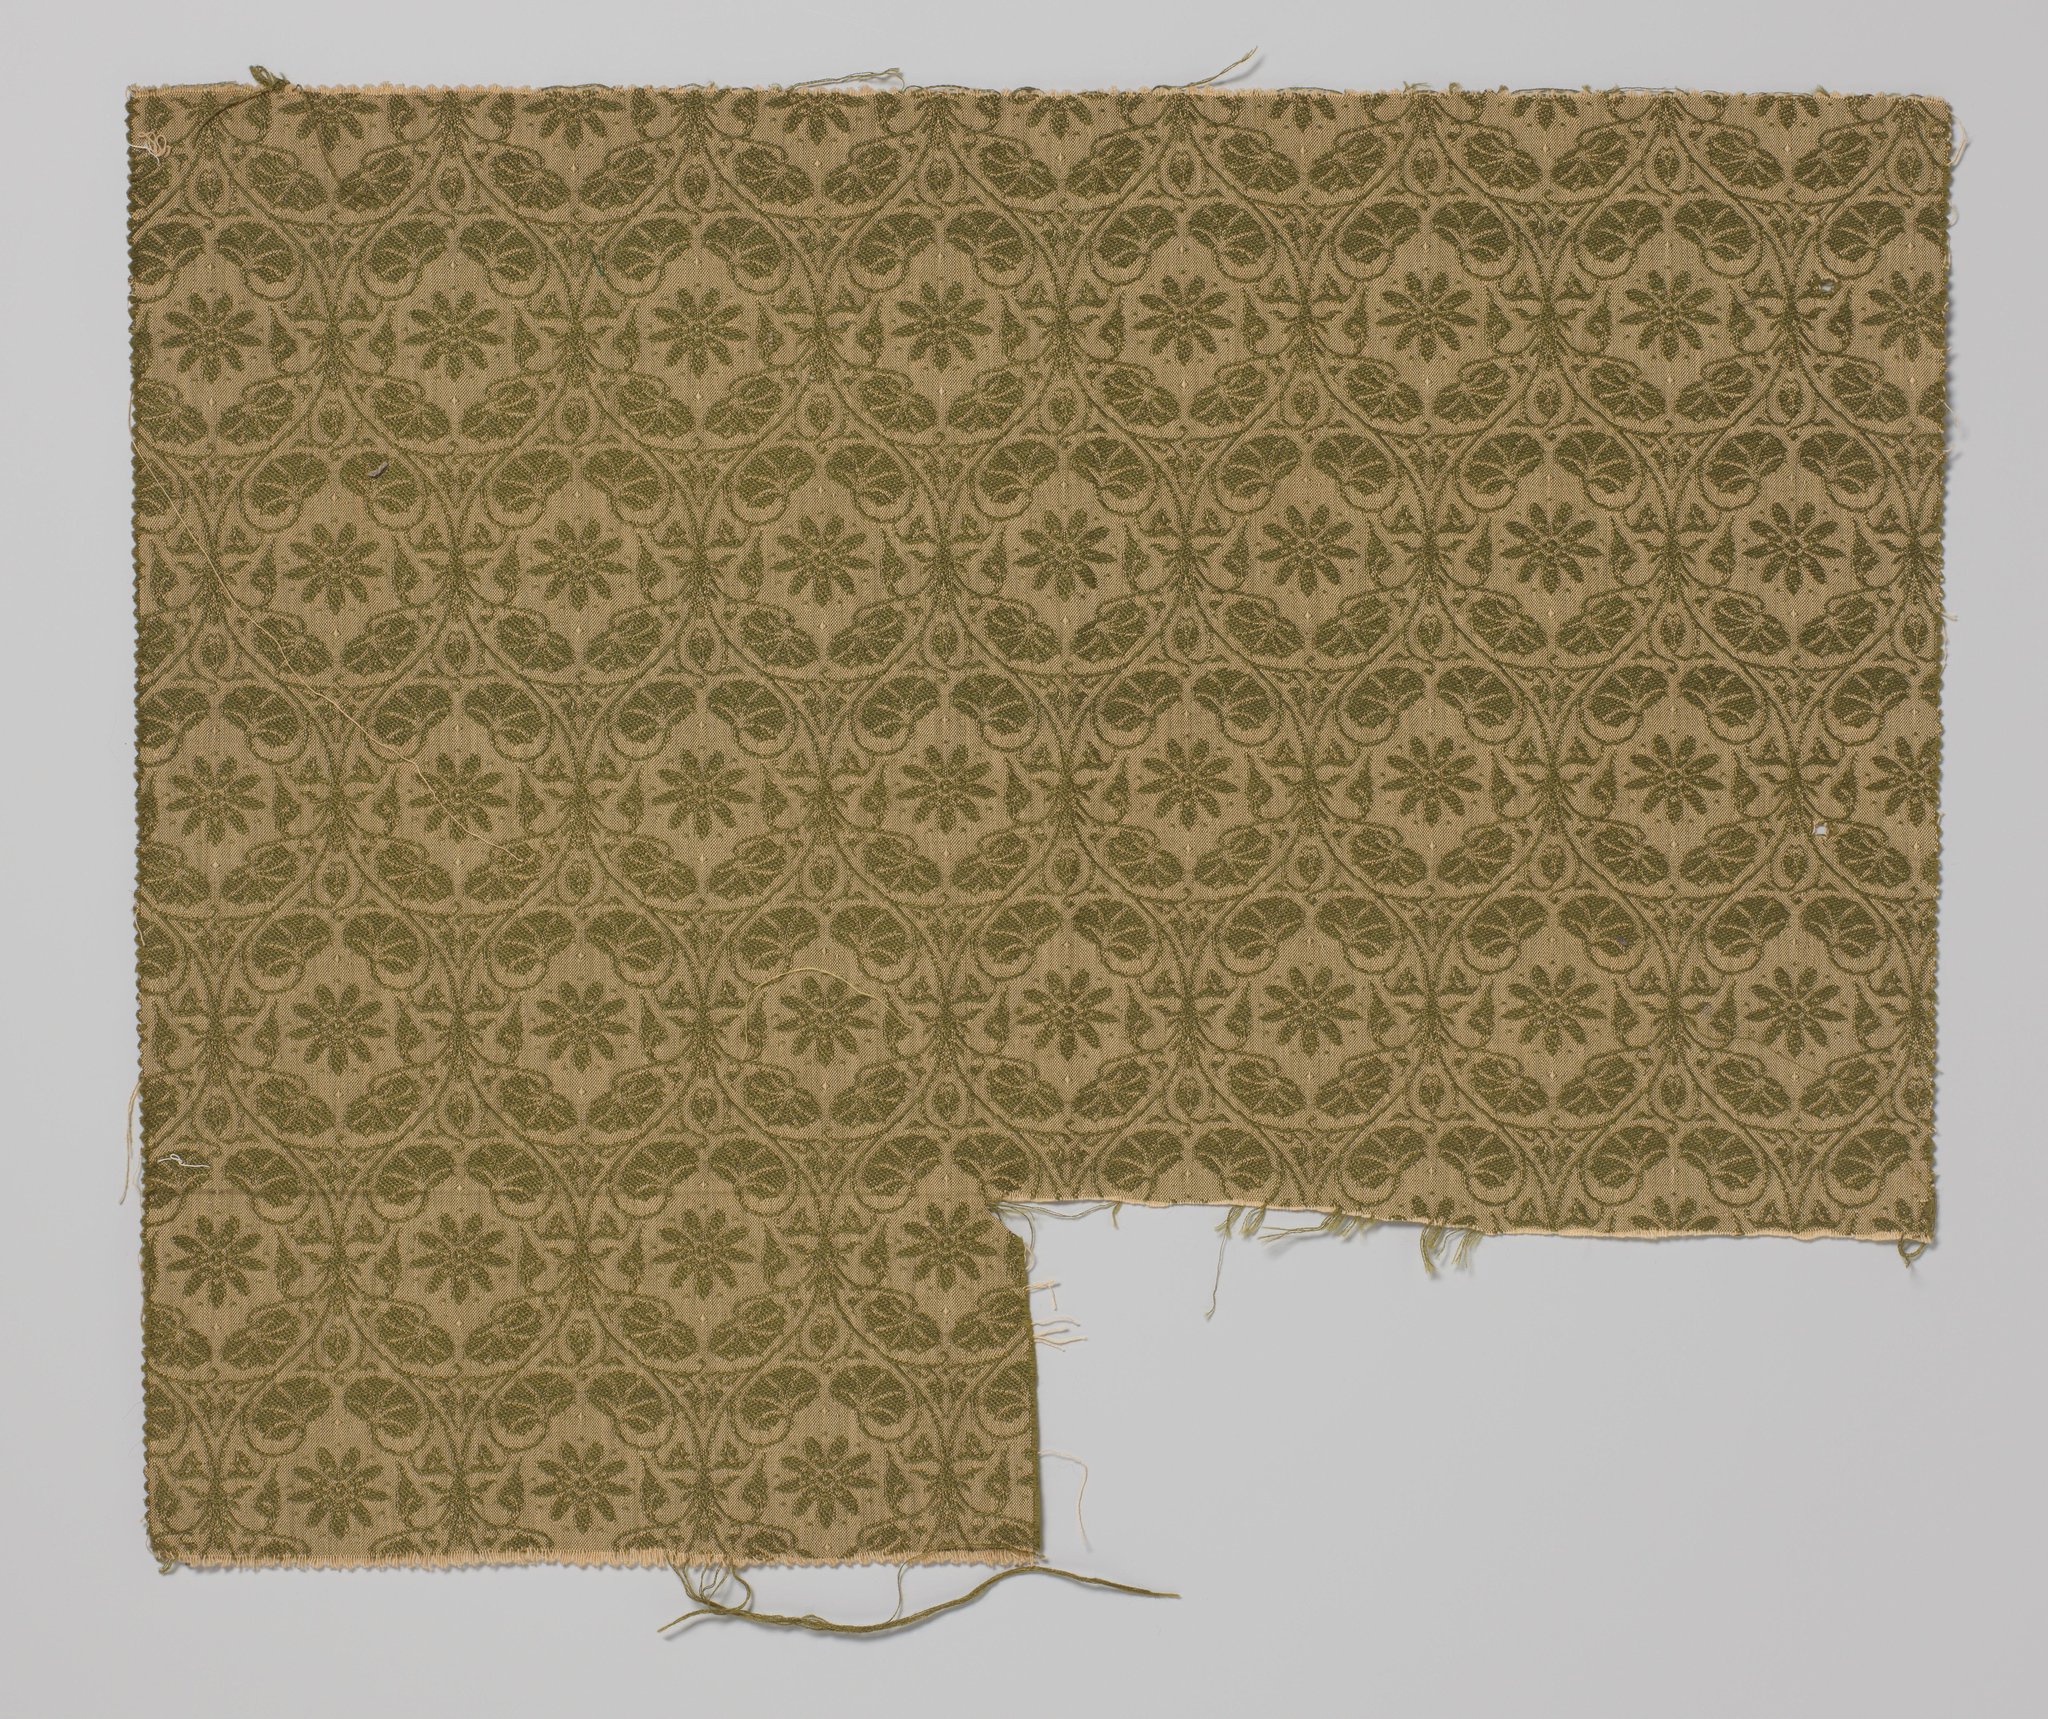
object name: upholstered wall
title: Fragment bespanningsstof met bloem binnen spitsovalen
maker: theo nieuwenhuis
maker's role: designer, draughtsman, print maker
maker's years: 1866-1951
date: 1900-1925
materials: cotton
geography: netherlands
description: Fragment bespanningsstof met bloem binnen spitsovalen. Olijfgroene inslag op beige ketting. Linksboven een stuk van 9.5 x 24.5 cm uitgeknipt. Dessinnummer 244.